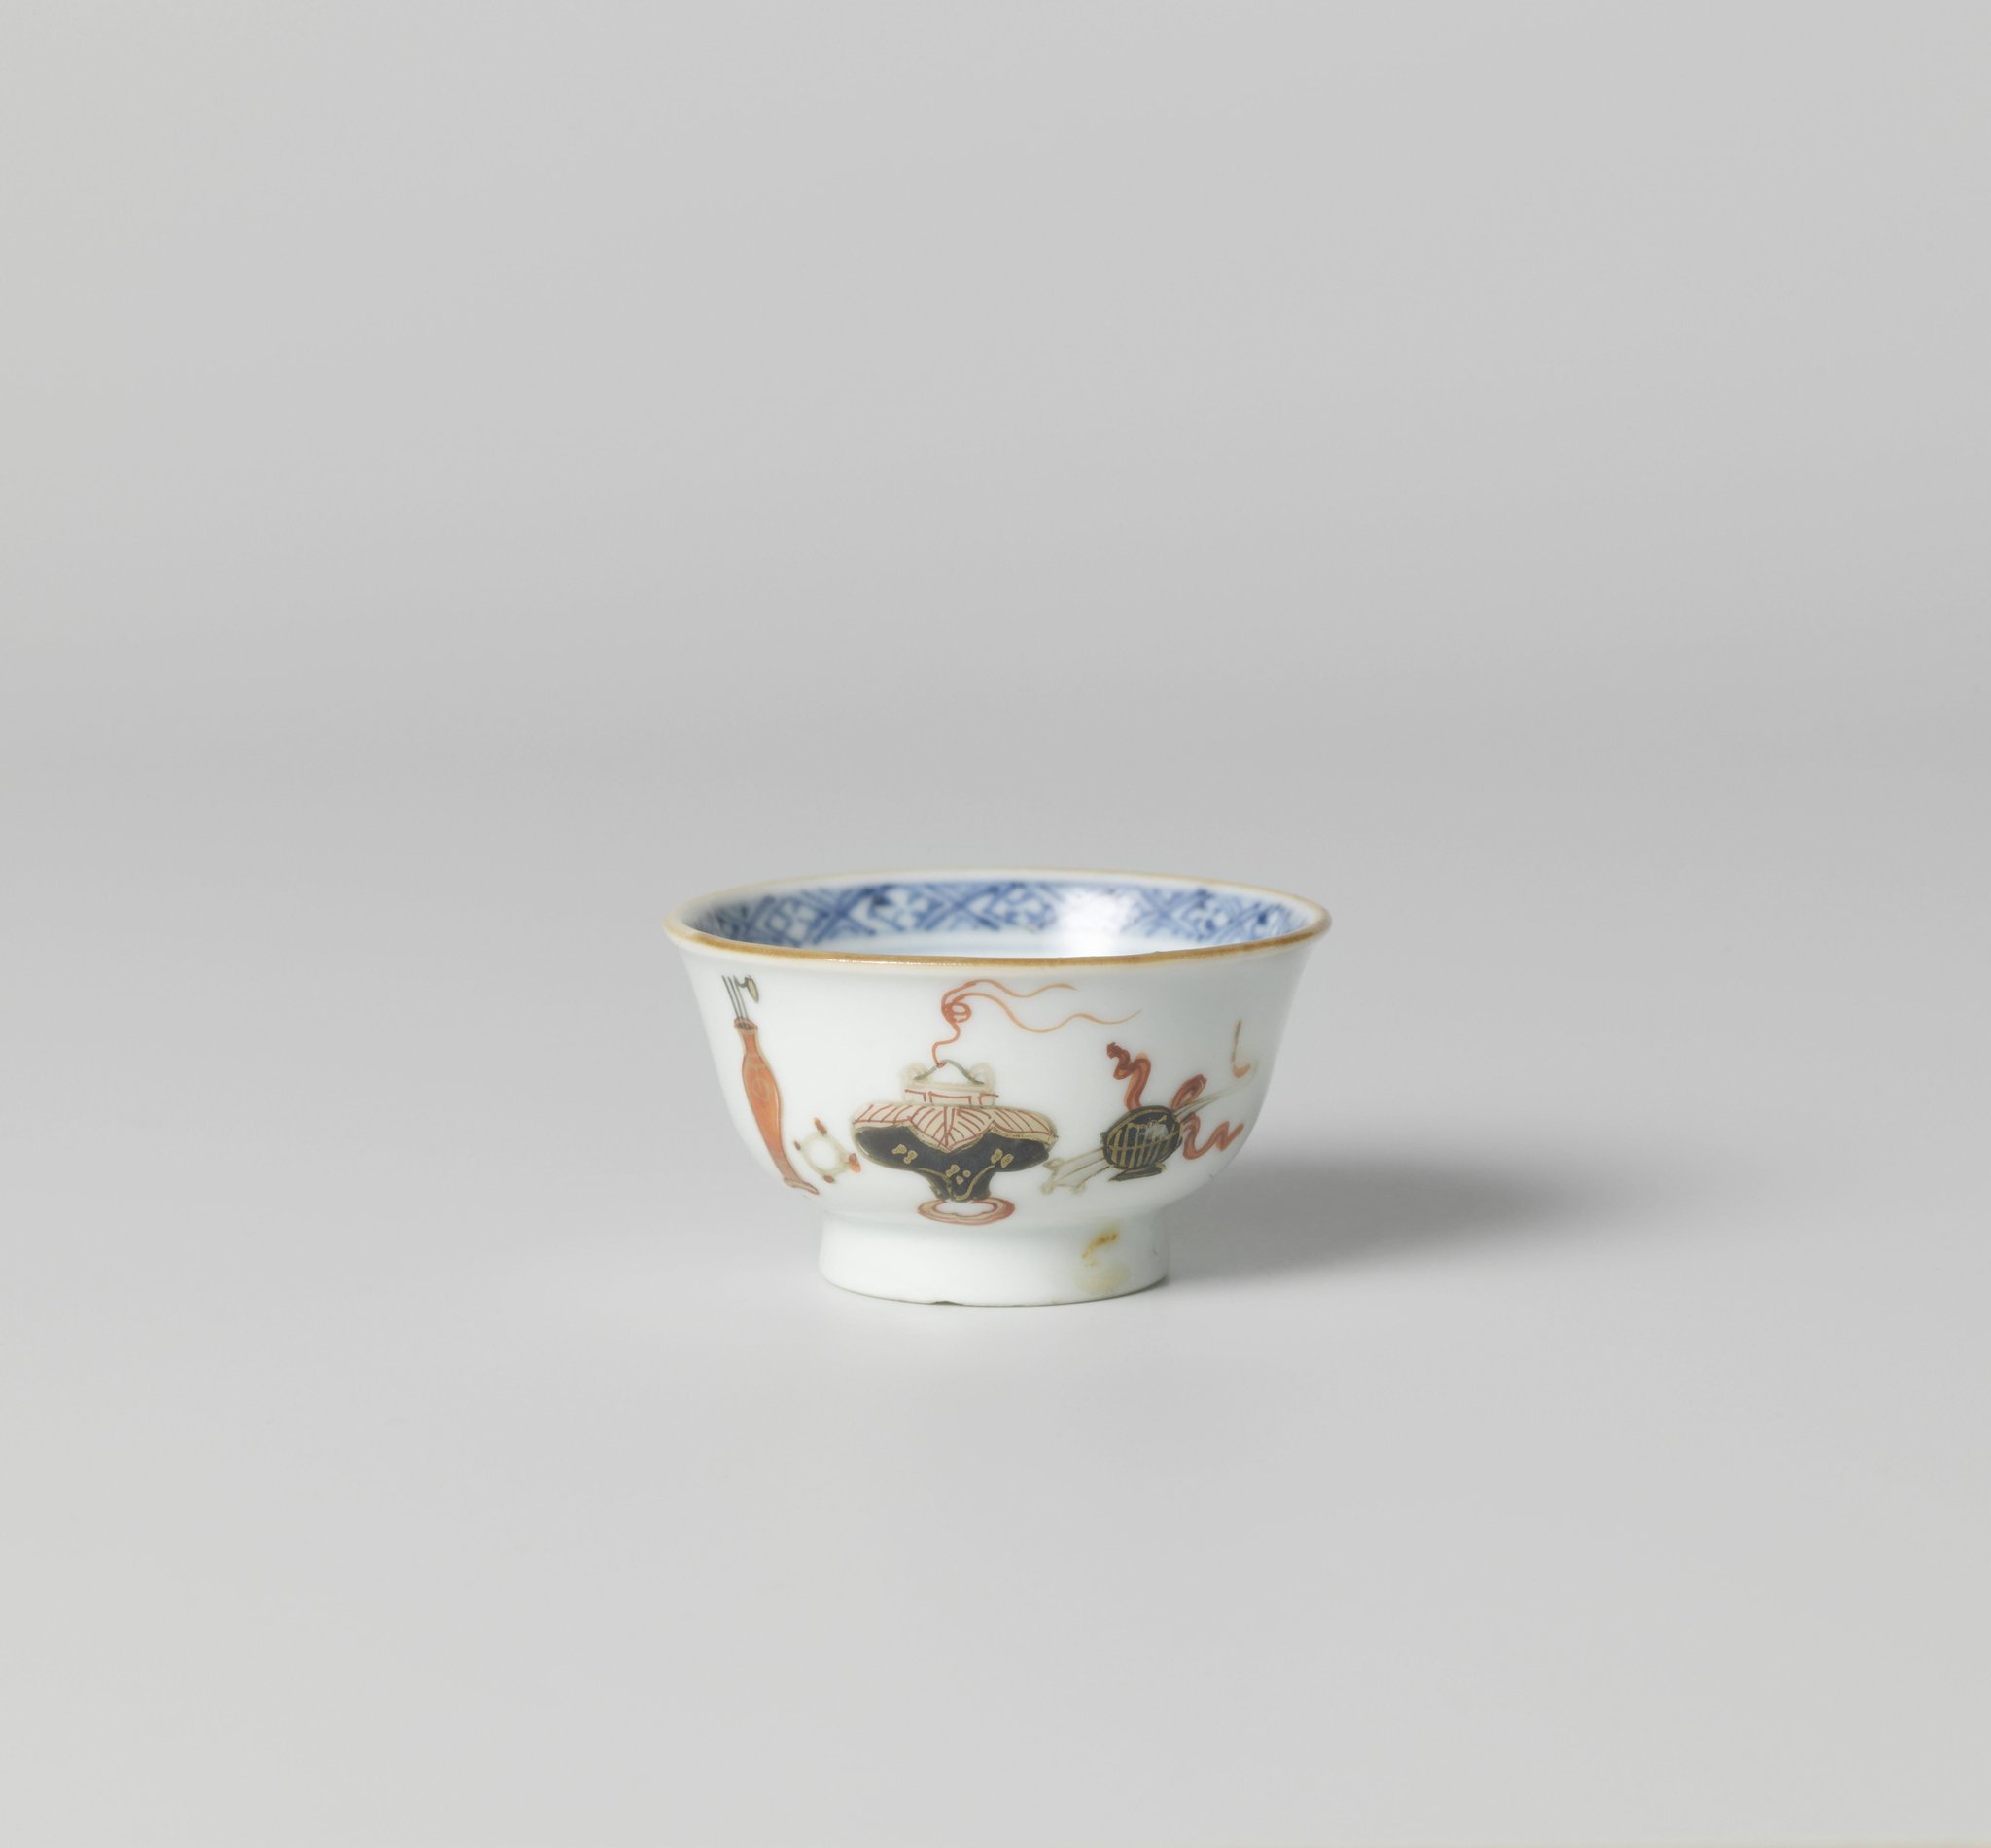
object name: cup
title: Bell-shaped cup with antiquities and diaper pattern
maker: Anonymous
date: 1725-1749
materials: glaze, gold, paint, porcelain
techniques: firing, gilding, turning, vitrification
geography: china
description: Klokvormige kop van porselein, beschilderd in onderglazuur blauw en op het glazuur rood, groen, zwart en goud. Een groep antiquiteiten (vaas met pauwenveren en koraal, scepter, fruitschaal met vingercitroen, wierookbrander) afgebeeld; de rand met een band servetwerk. Famille verte.